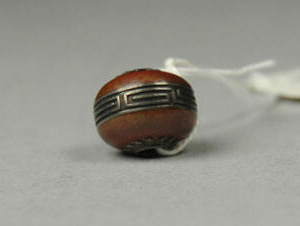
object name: ojime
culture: japanese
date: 1801-1900